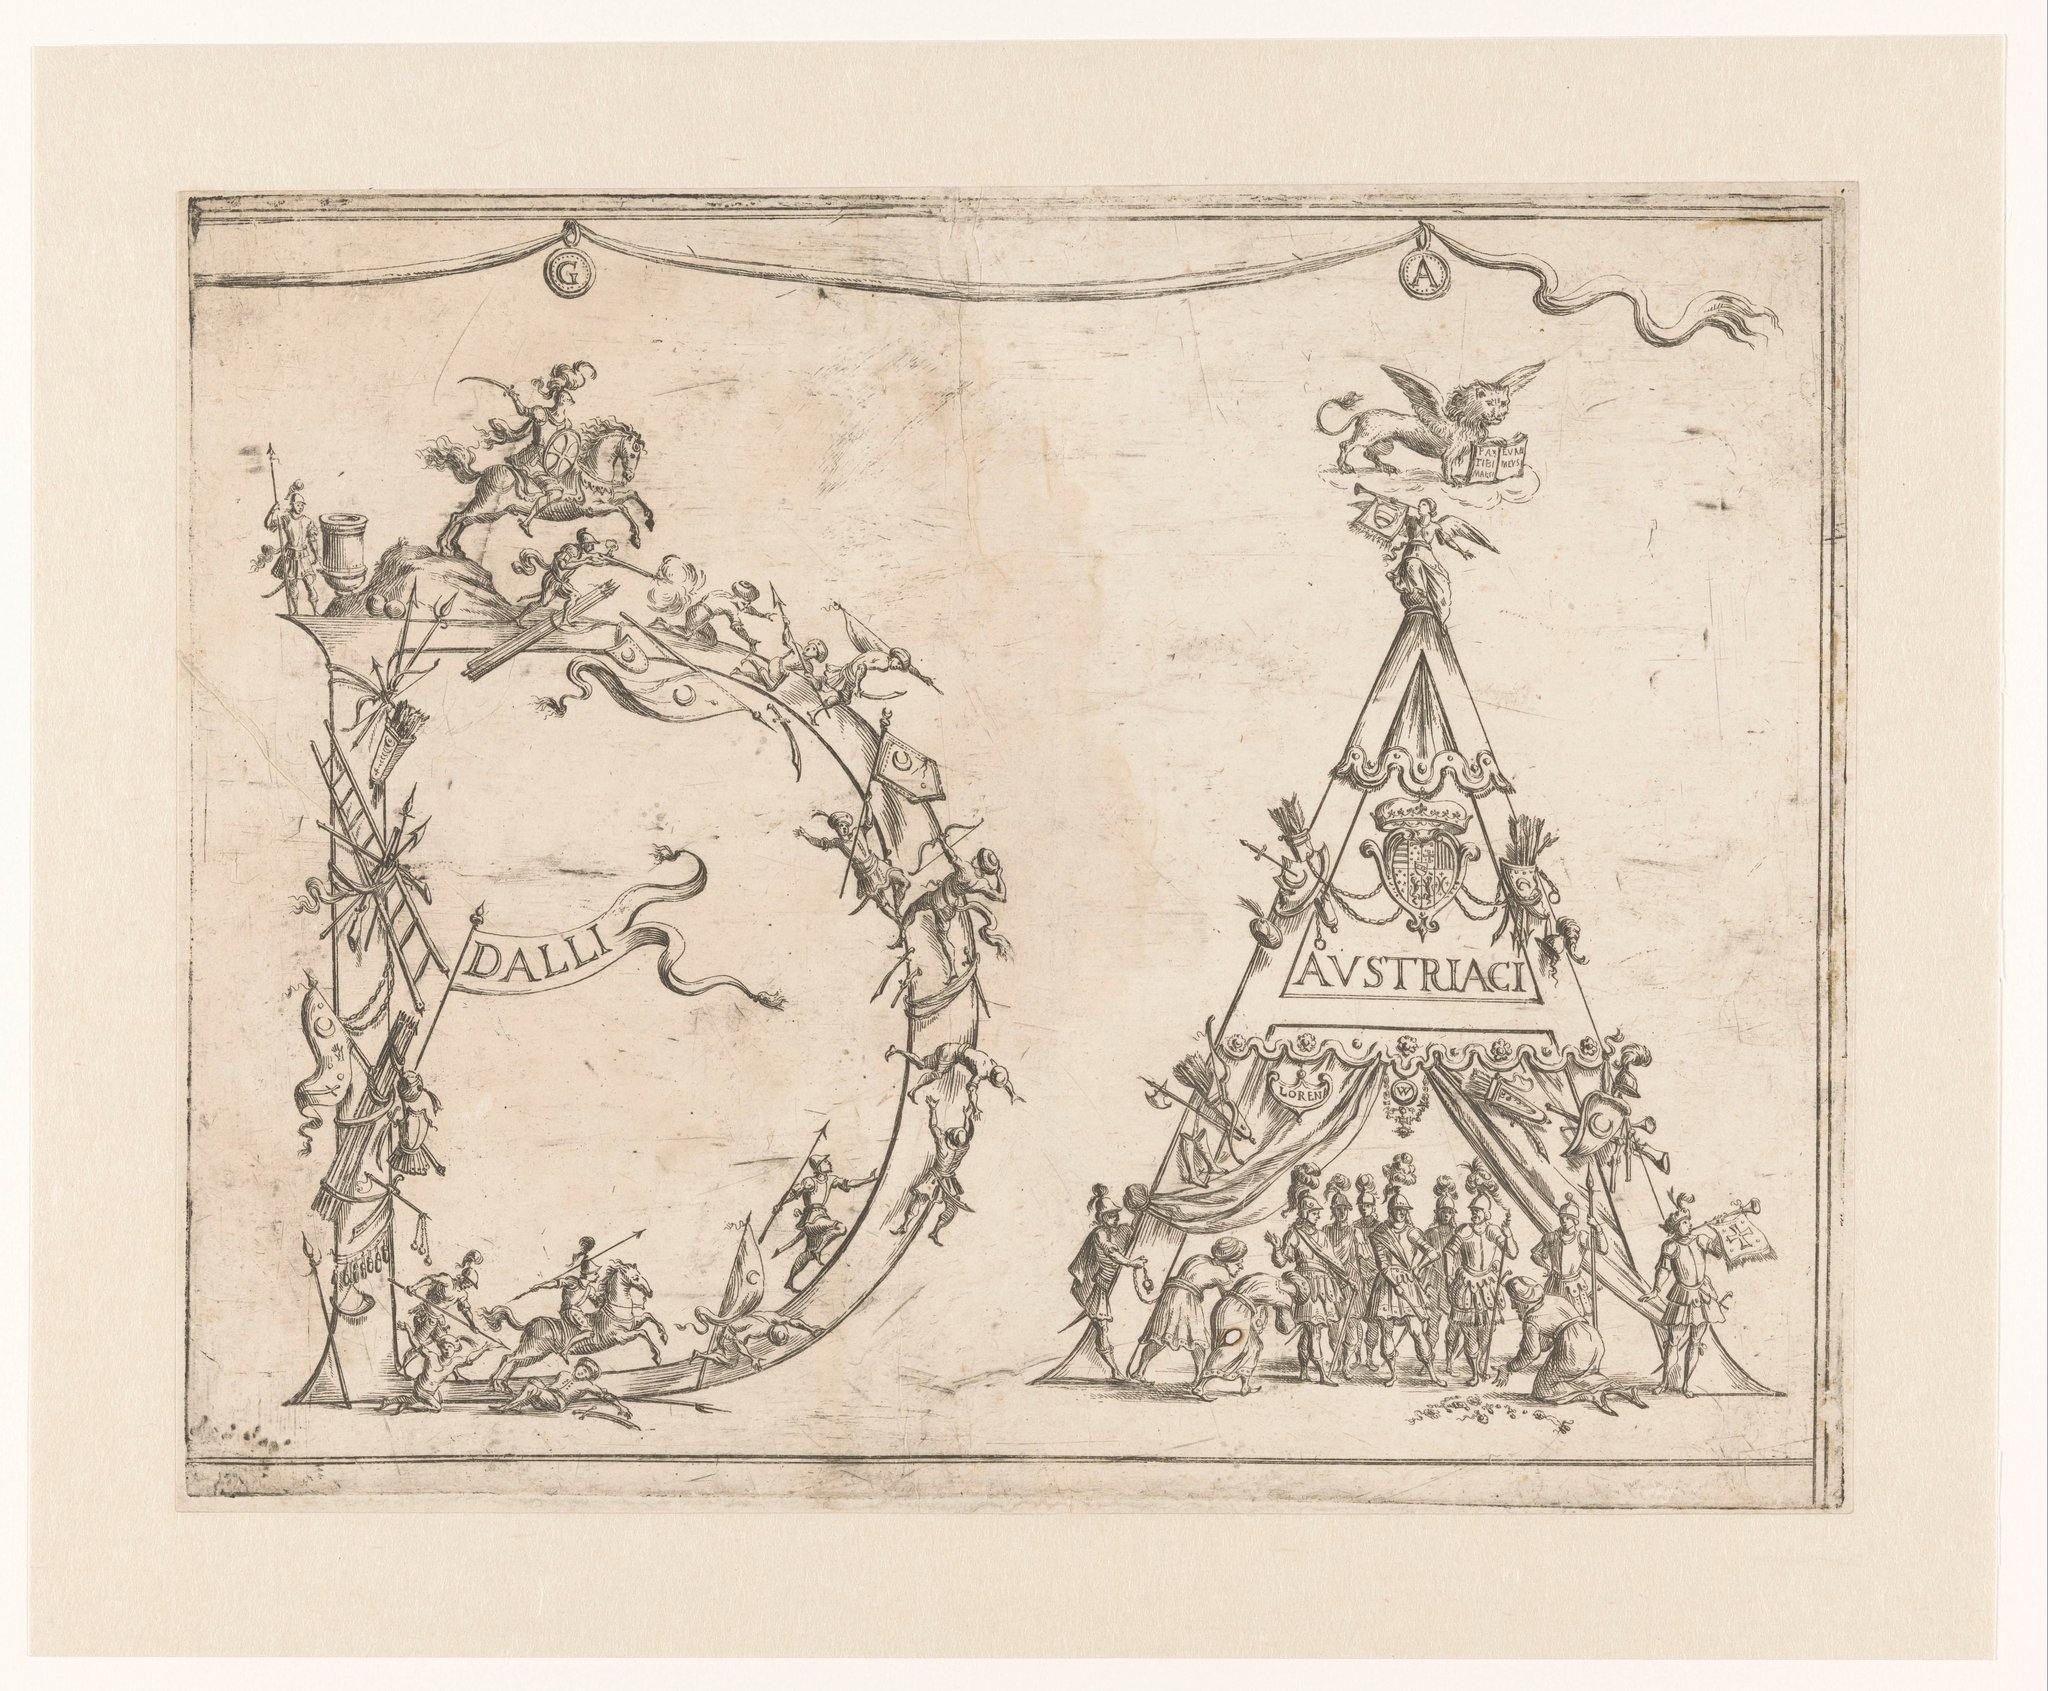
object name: print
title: Buda vinta dalli austraci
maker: giuseppe maria mitelli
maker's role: draughtsman, painter, print maker, publisher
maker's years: 1634-1718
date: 1686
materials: paper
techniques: etching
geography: italy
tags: fancy letters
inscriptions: collector's mark: Lugt 2228, collector's mark: Lugt 2760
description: De sierletters D en A. De letters zijn deels opgebouwd of voorzien van vededigingswerken, vaartuigen, wapens en soldaten. Daarboven de Venetiaanse wapens. Prent ter ere van de herovering van Buda op de Turken in 1686.